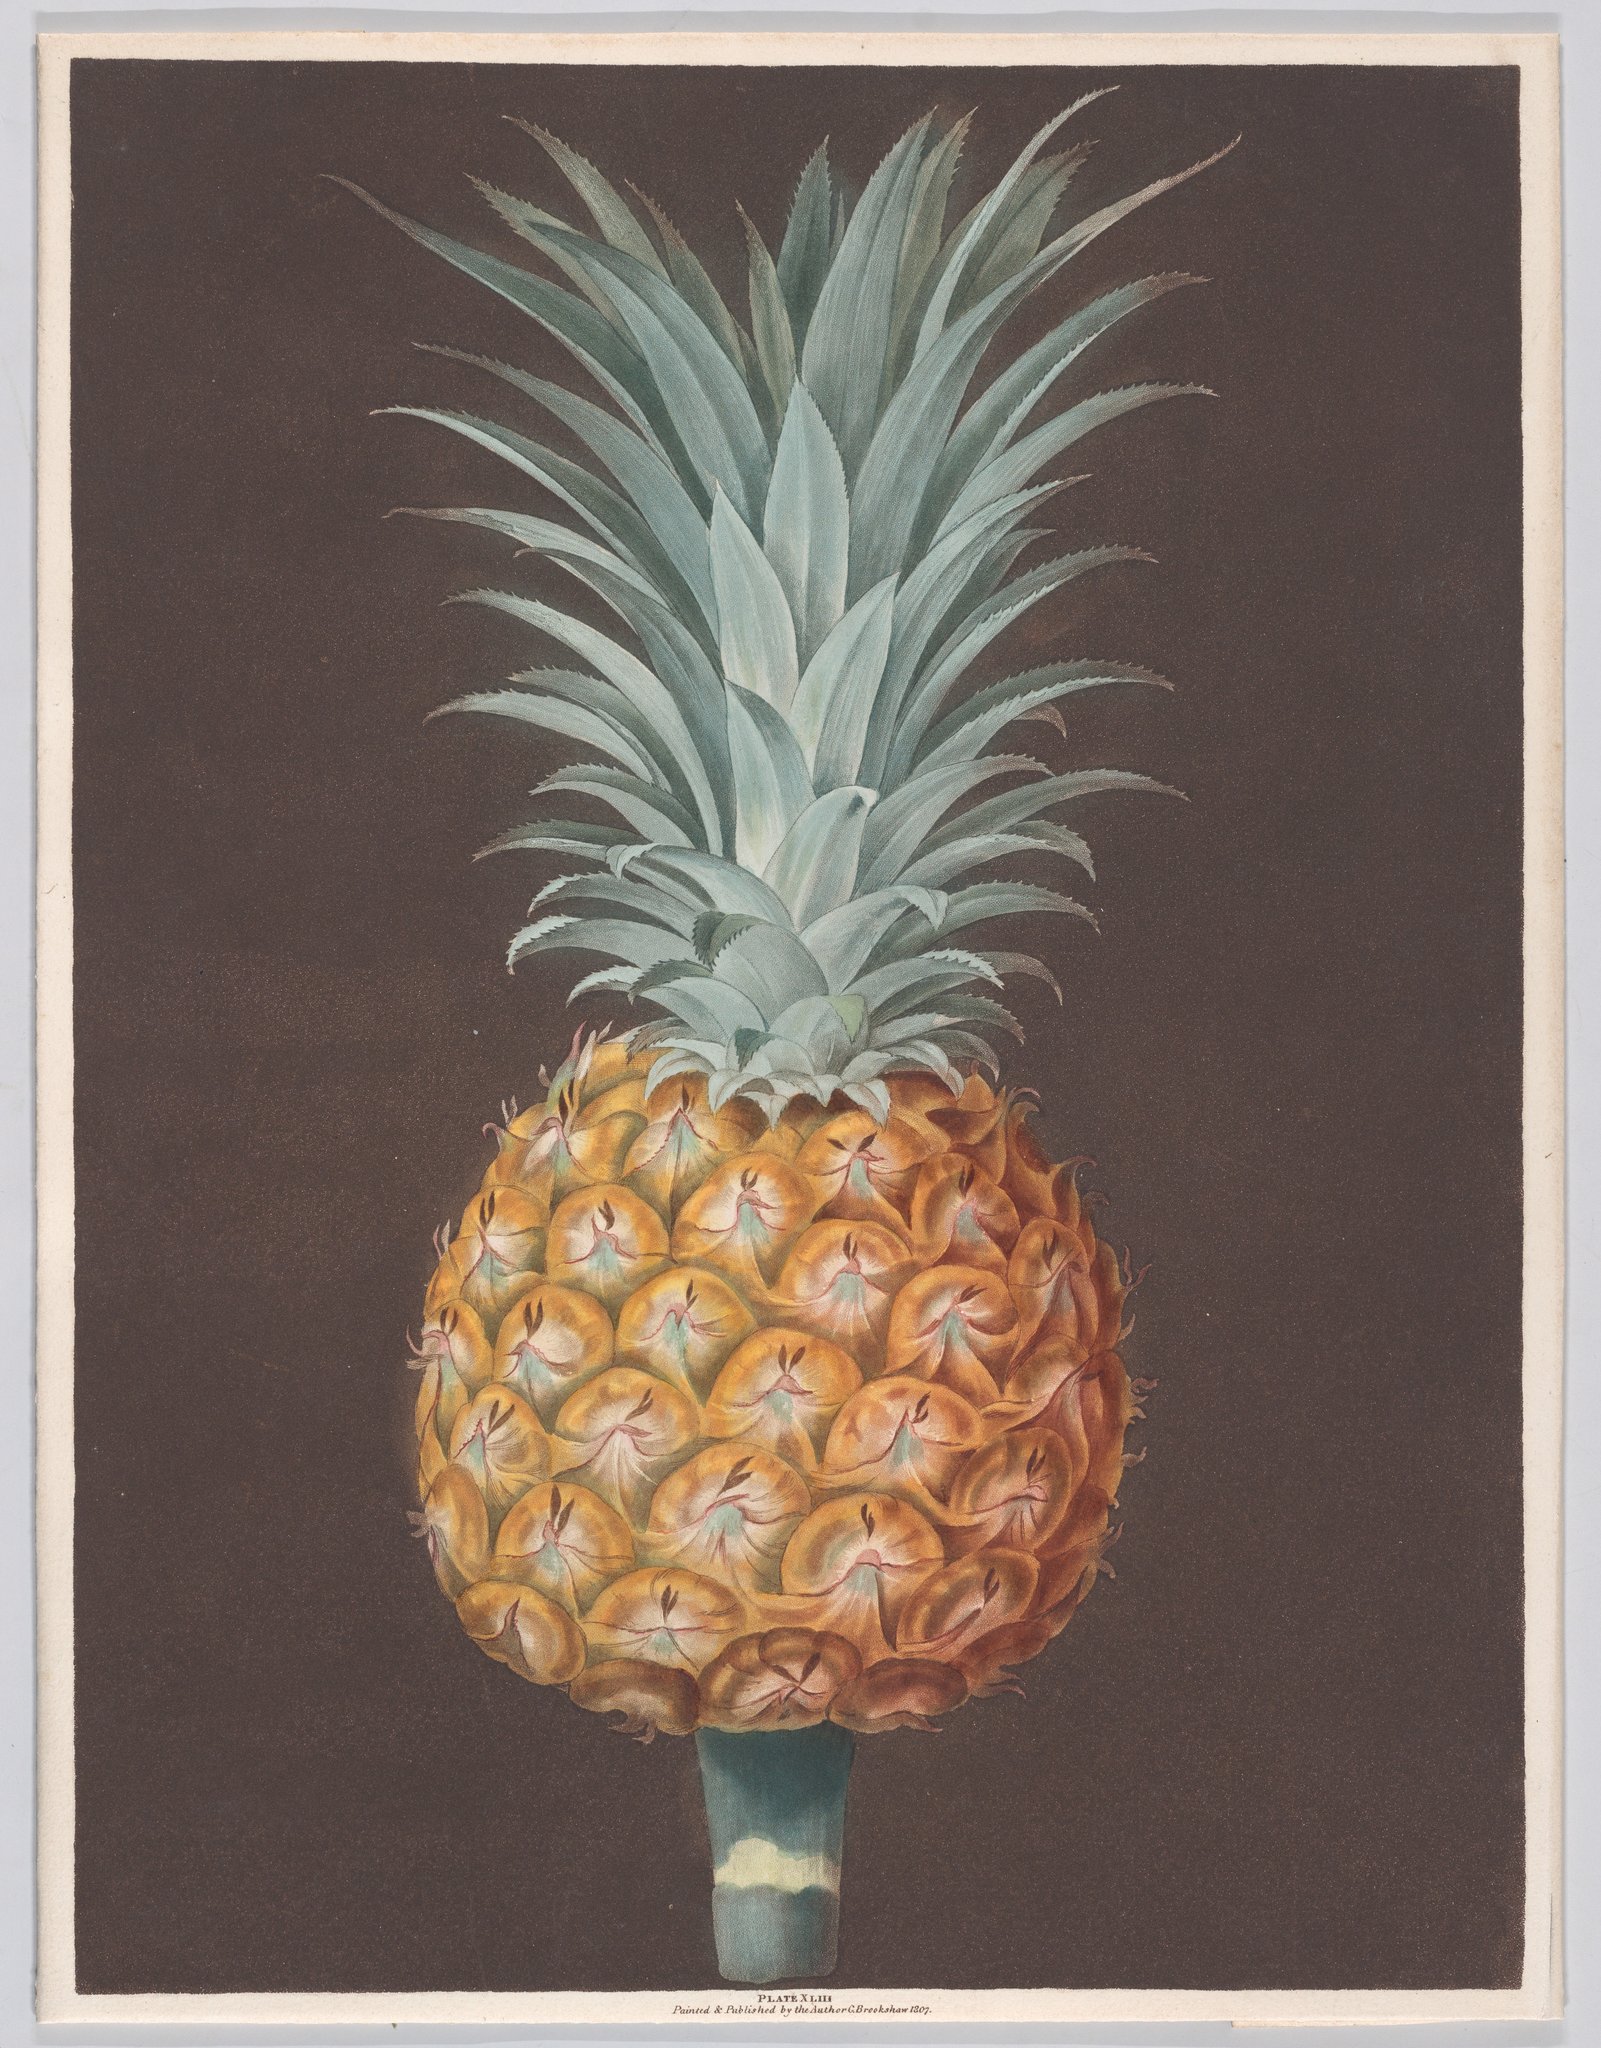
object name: print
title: The Brown Havannah Pine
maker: george brookshaw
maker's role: artist and publisher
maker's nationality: british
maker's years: 1751-1823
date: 1807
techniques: aquatint, hand coloring, printing, stippling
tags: pineapples